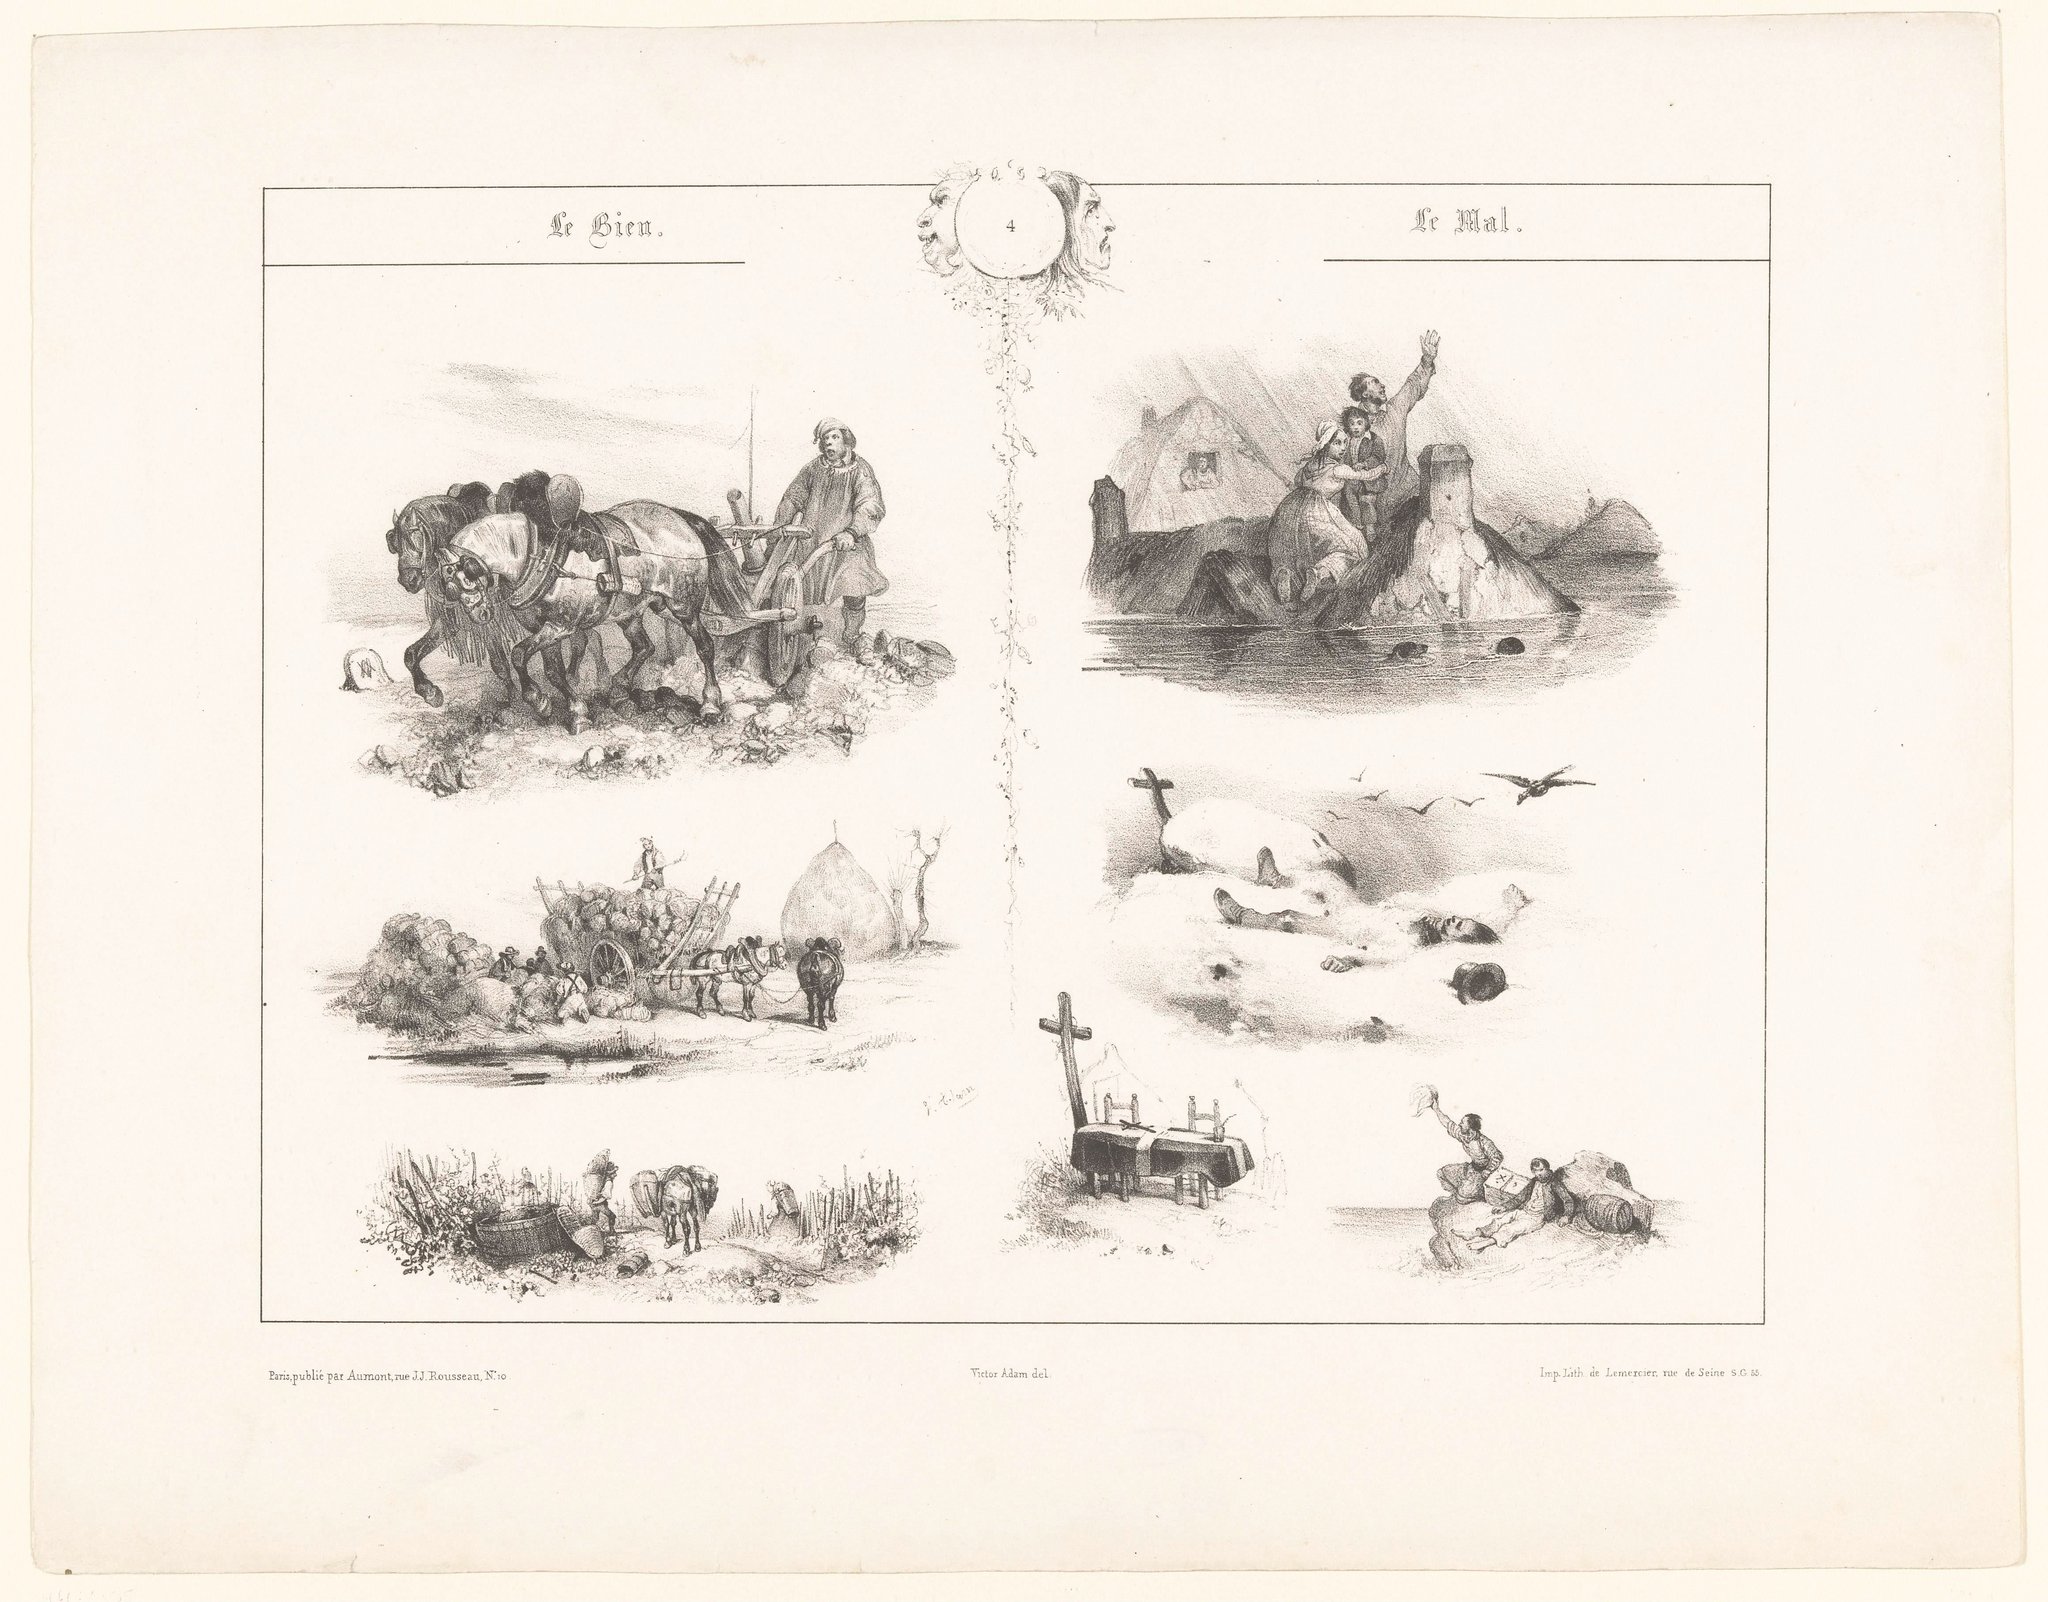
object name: print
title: Drie voorstellingen van goede dingen en drie voorstellingen van kwade dingen in het leven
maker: victor adam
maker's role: painter, print maker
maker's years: 1801-1866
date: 1837-1838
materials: paper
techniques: lithograph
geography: paris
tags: good, right, bad, evil, wrong, agriculture, death of human being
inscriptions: collector's mark: Lugt 2228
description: Links drie goede dingen in het leven: land- en wijnbouw. Rechts drie kwade dingen in het leven: overstroming, dood, schipbreuk.